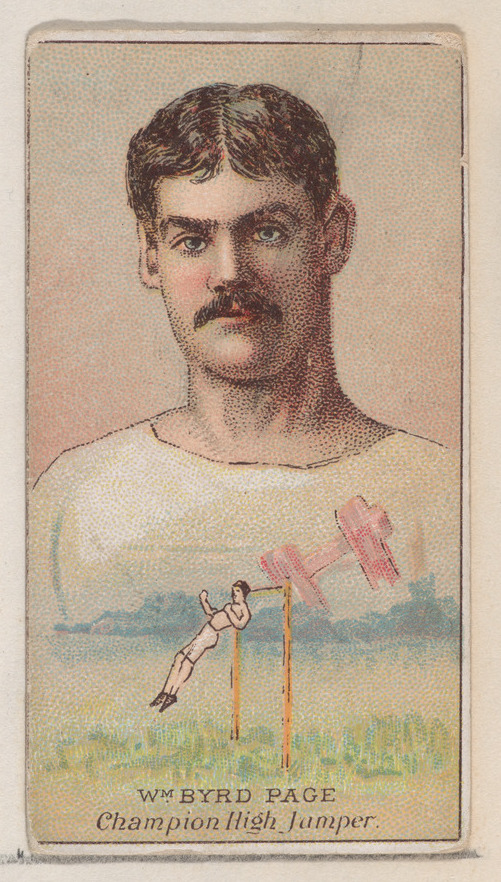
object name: print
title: William Byrd Page, Champion High Jumper, from the Champions of Games and Sports series (N184, Type 2) issued by W.S. Kimball & Co.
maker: w.s. kimball & co.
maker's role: publisher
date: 1887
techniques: color lithograph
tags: men,sports,athletes